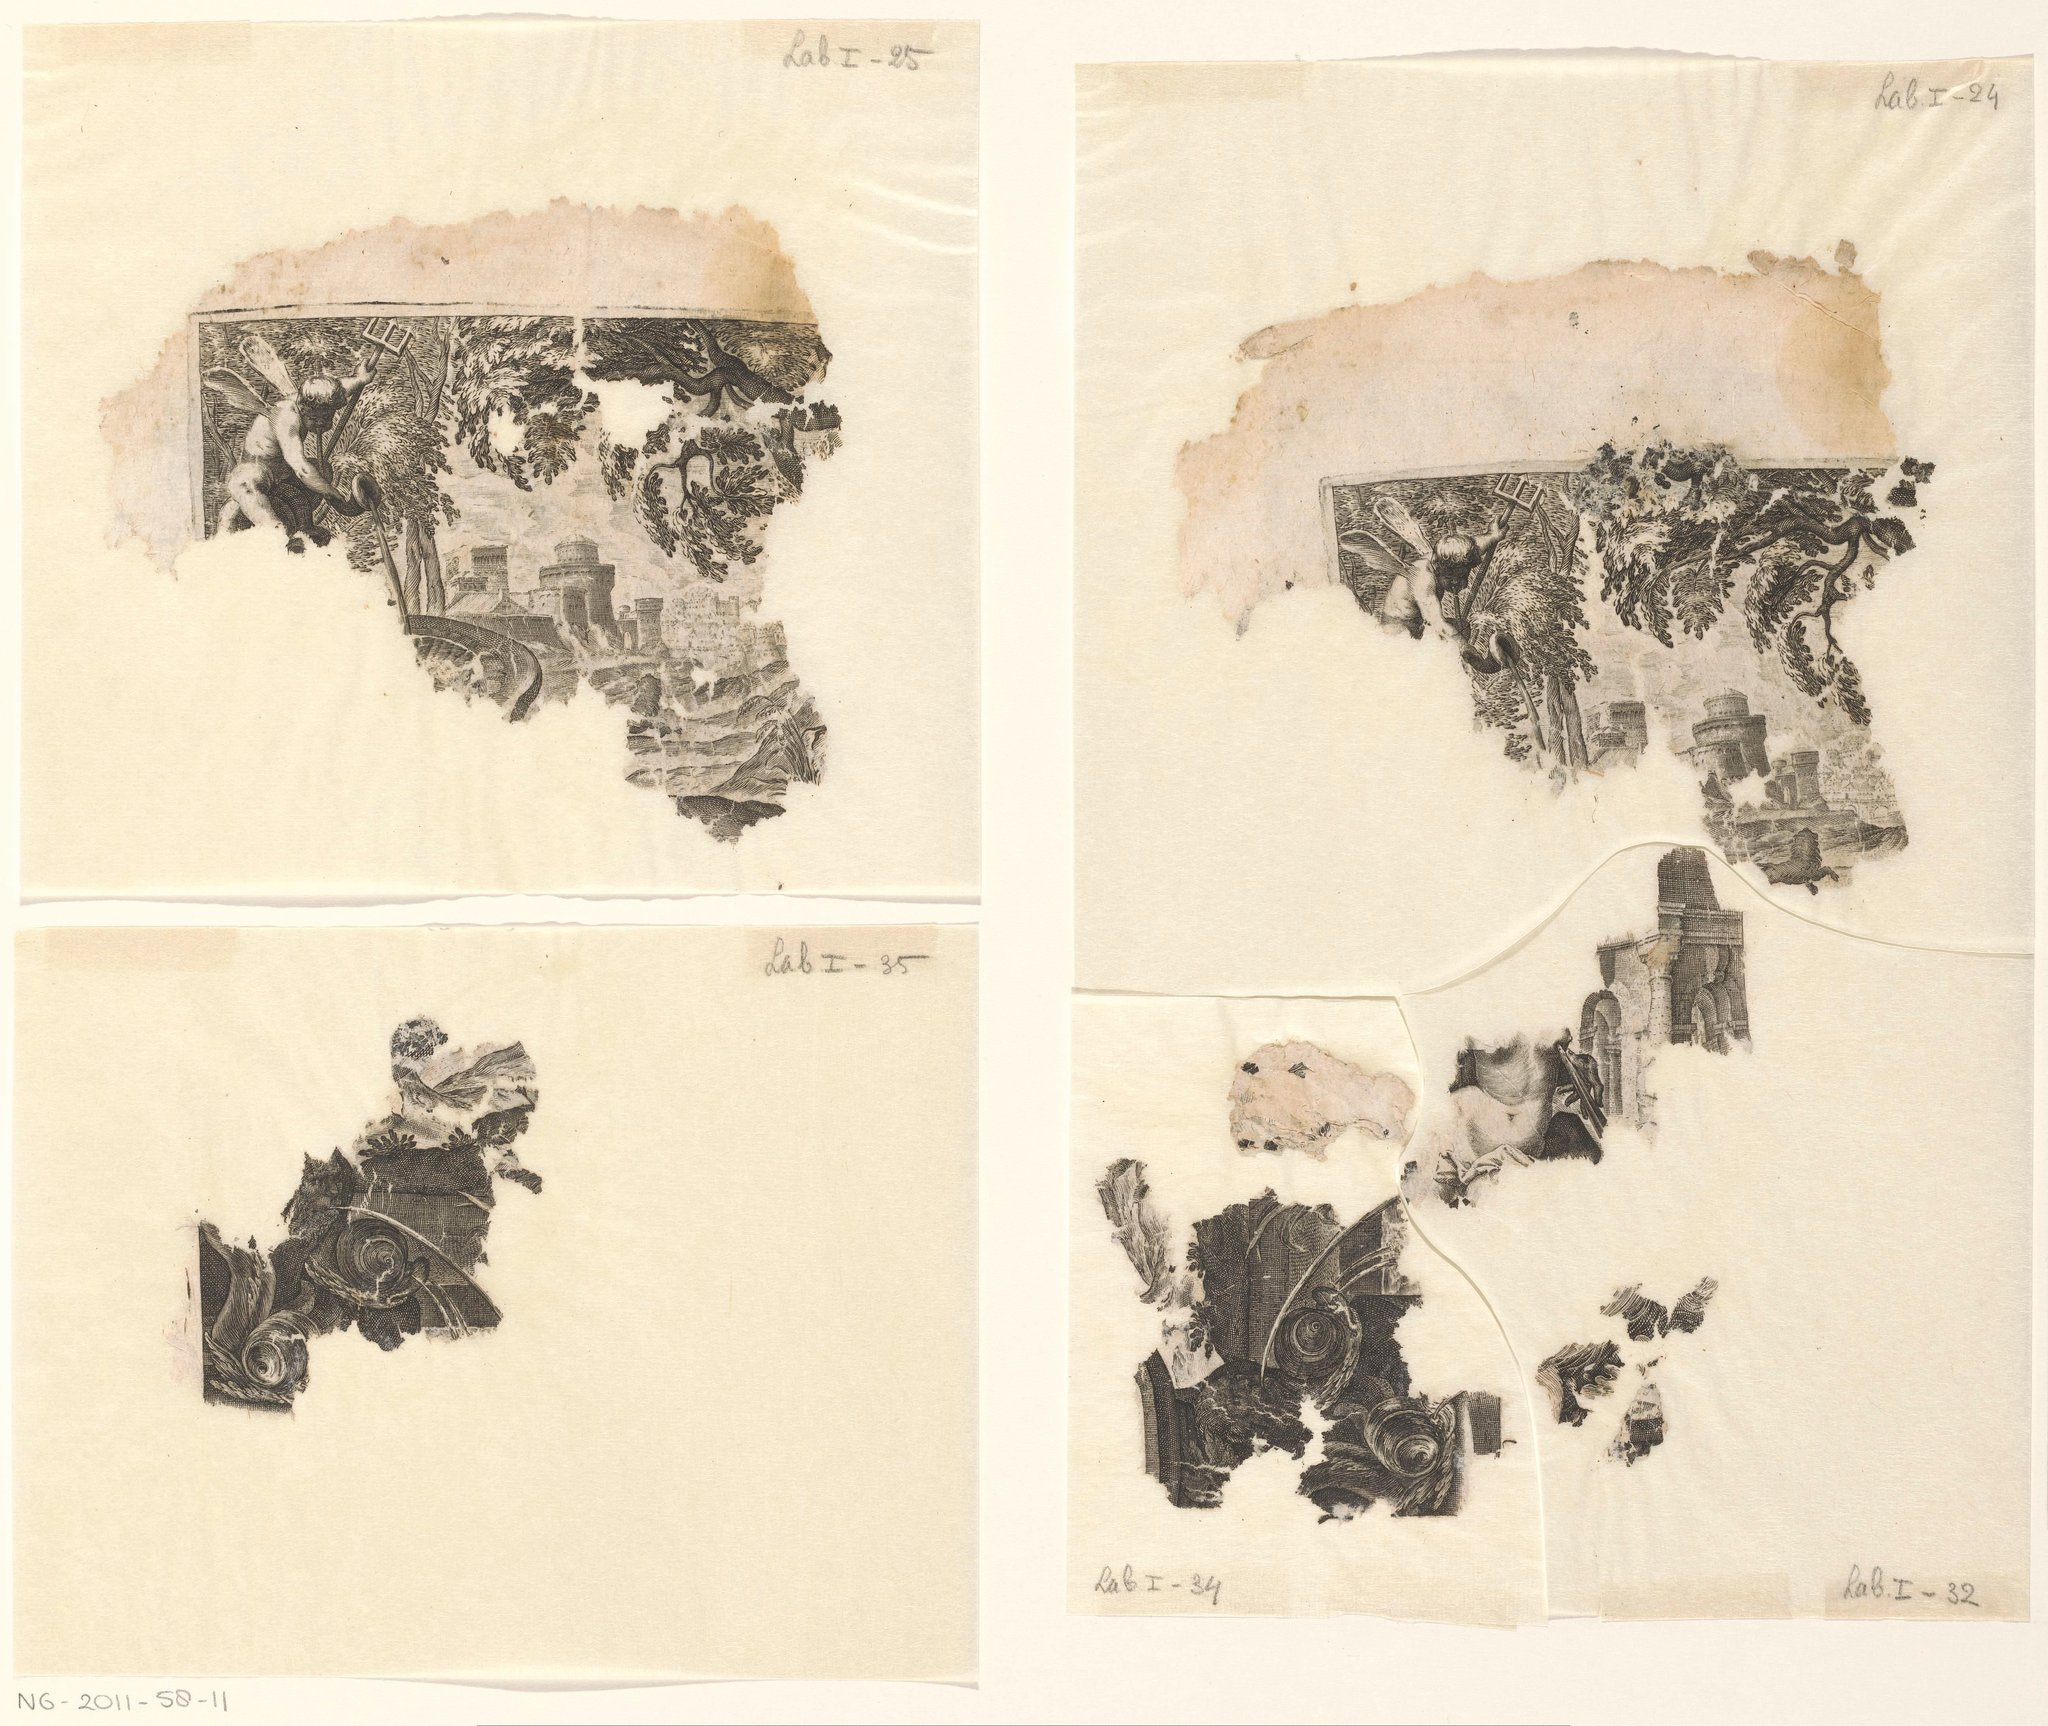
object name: print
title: Losse fragmenten van een prent van Pyramus en Thisbe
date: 1580-1596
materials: paper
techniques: engraving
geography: northern netherlands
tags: thisbe kills herself with pyramus' sword (the scene may be represented near a fountain)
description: De prenten in de Nova Zembla collectie zijn tijdens een expeditie van Willem Barendsz en Jacob van Heemskerk in 1596-1597 noodgedwongen in het winterkamp, het ‘Behouden Huis’, op het eiland achtergelaten. De prenten waren in één of meerdere stapels als handelswaar meegenomen vanuit Amsterdam. Bijna drie eeuwen later, in 1871, keerde de Noor Elling Carlsen terug naar Nova Zembla en vond daar de restanten van het ‘Behouden Huis, inclusief een groot deel van de inventaris. Een deel van de prenten, in de vorm van aaneengekoekte kluiten, werd toen ook teruggevonden. De papierkluiten waren soms op meerdere plekken gebroken. Tussen 1975-1979 zijn de prenten van elkaar gescheiden. Dit leverde in totaal ca. 1000 fragmenten van ca. 400 afdrukken van ca. 150 verschillende prenten op. Voor zover mogelijk zijn de fragmenten samengevoegd en zijn de prenten gereconstrueerd.